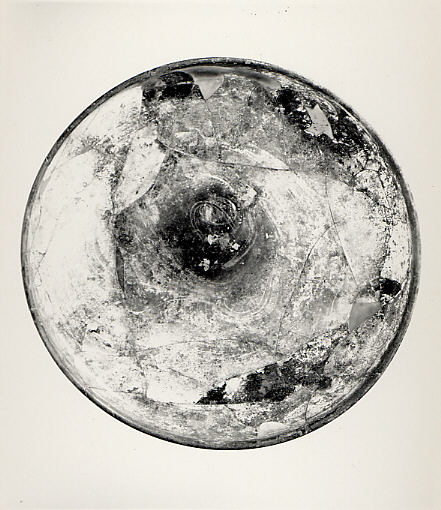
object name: plate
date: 967-1000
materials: glass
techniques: glassblowing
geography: iran